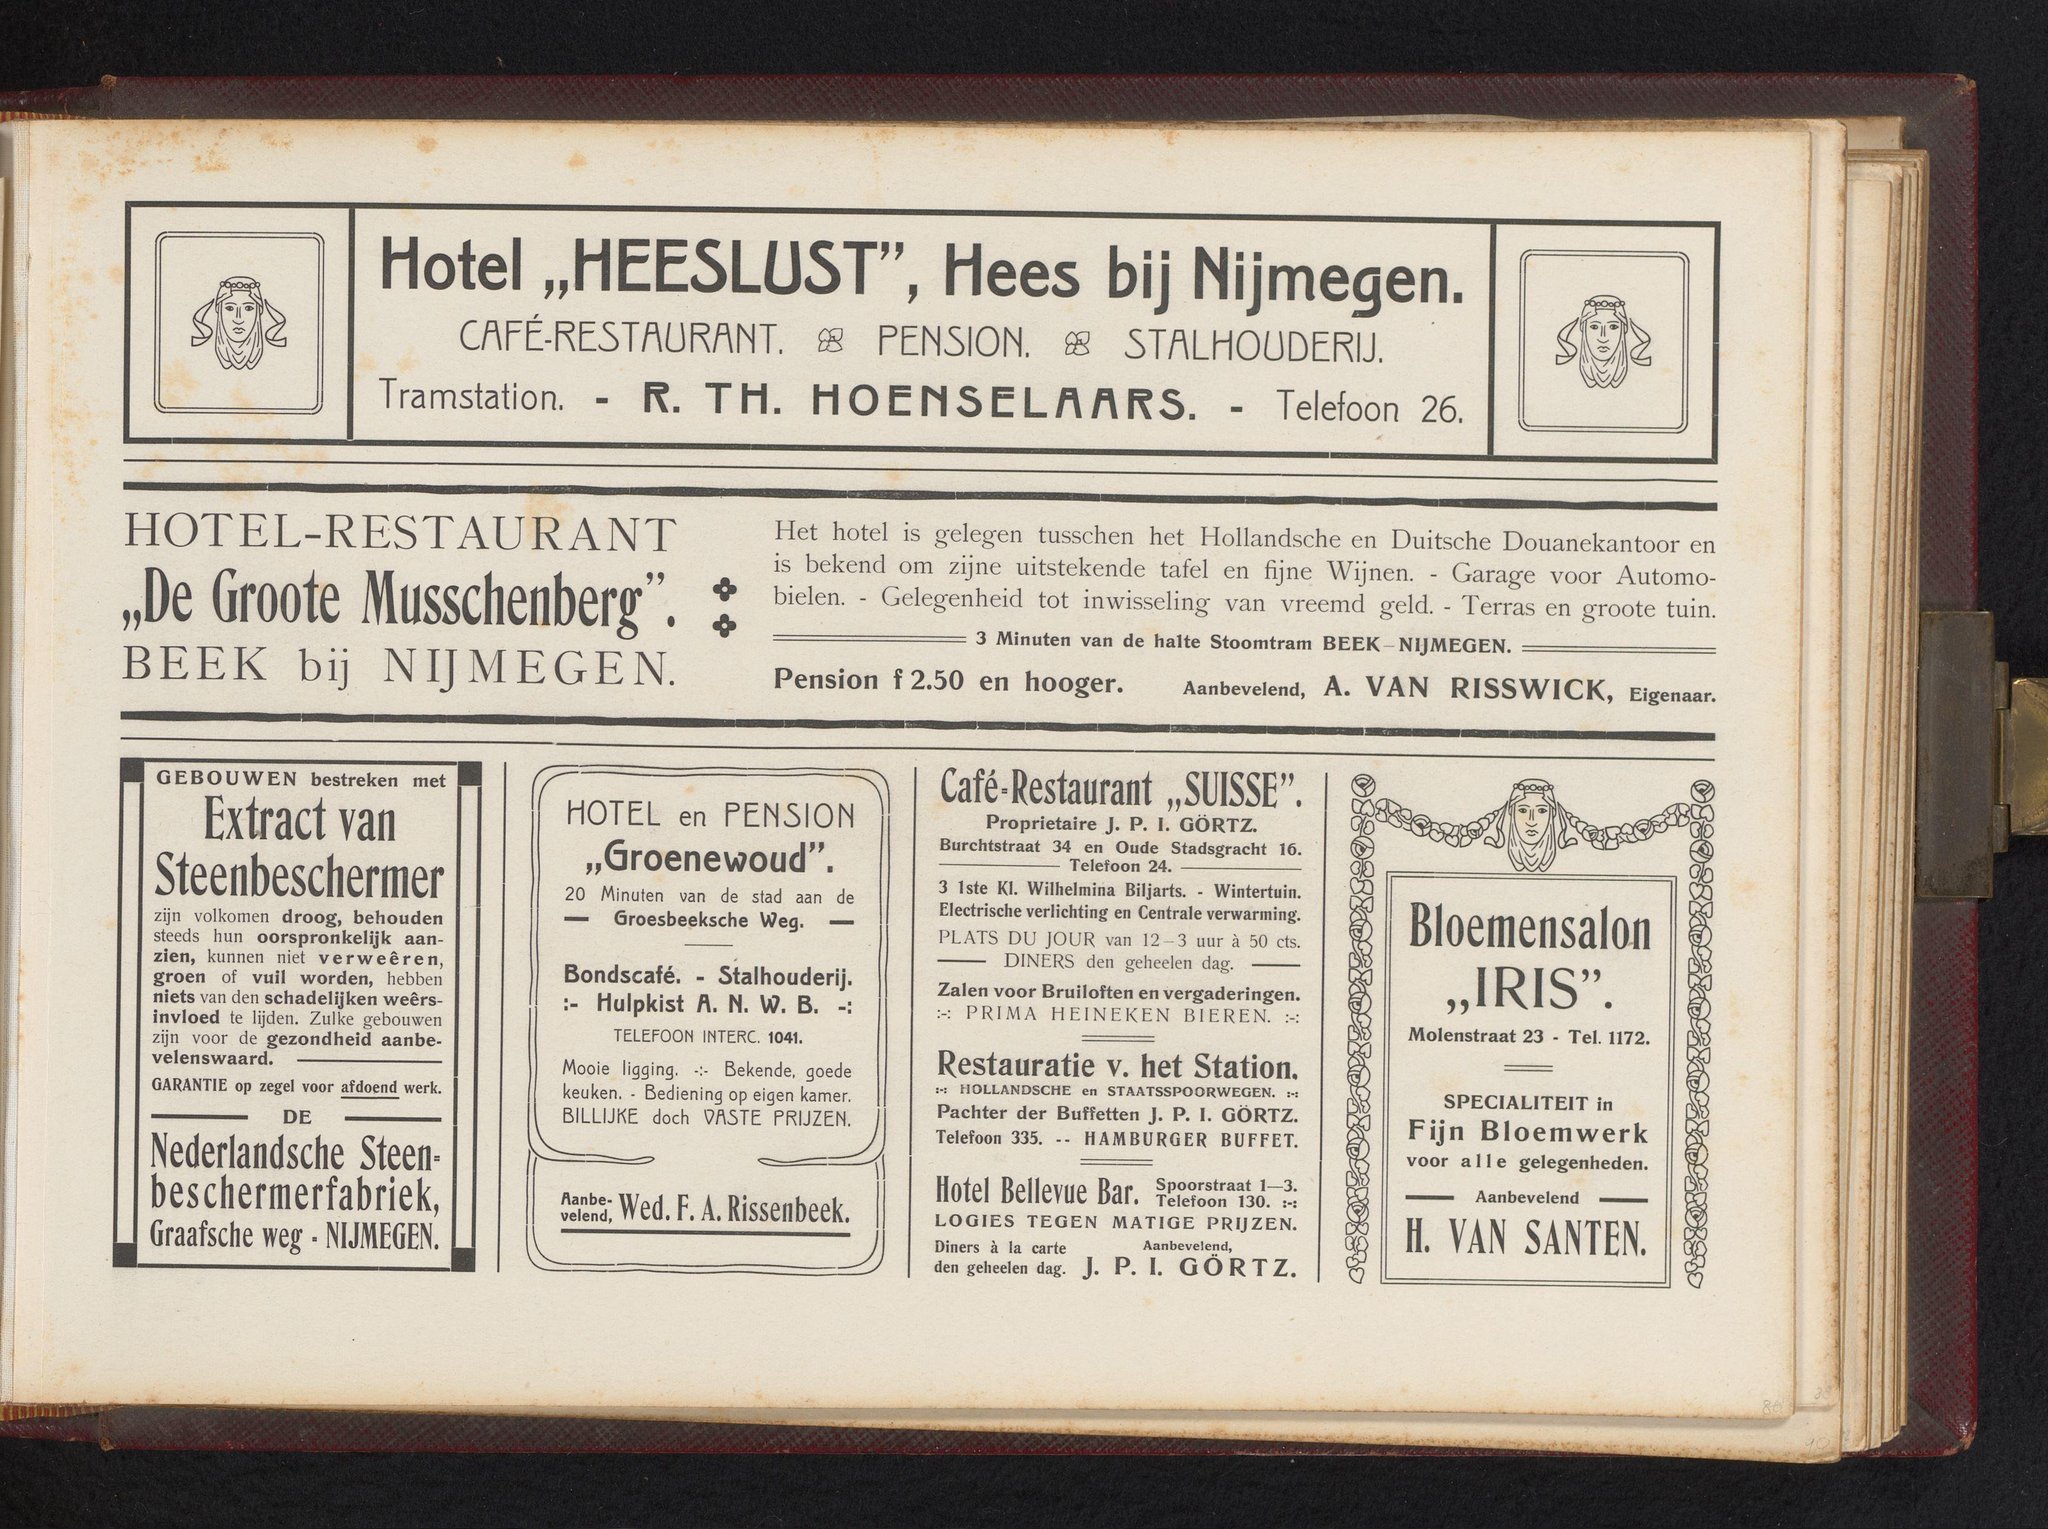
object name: album leaf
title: Advertenties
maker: Anonymous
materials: paper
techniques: printing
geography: netherlands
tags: advertising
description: Advertenties voor onder andere Hotel Heeslust, Hotel-Restaurant De Groote Musschenberg, De Nederlandsche Steenbeschermerfabriek, Hotel en pension Groenewoud, Café-restaurant Suisse en Bloemensalon Iris. Deze pagina maakt deel uit van een album.